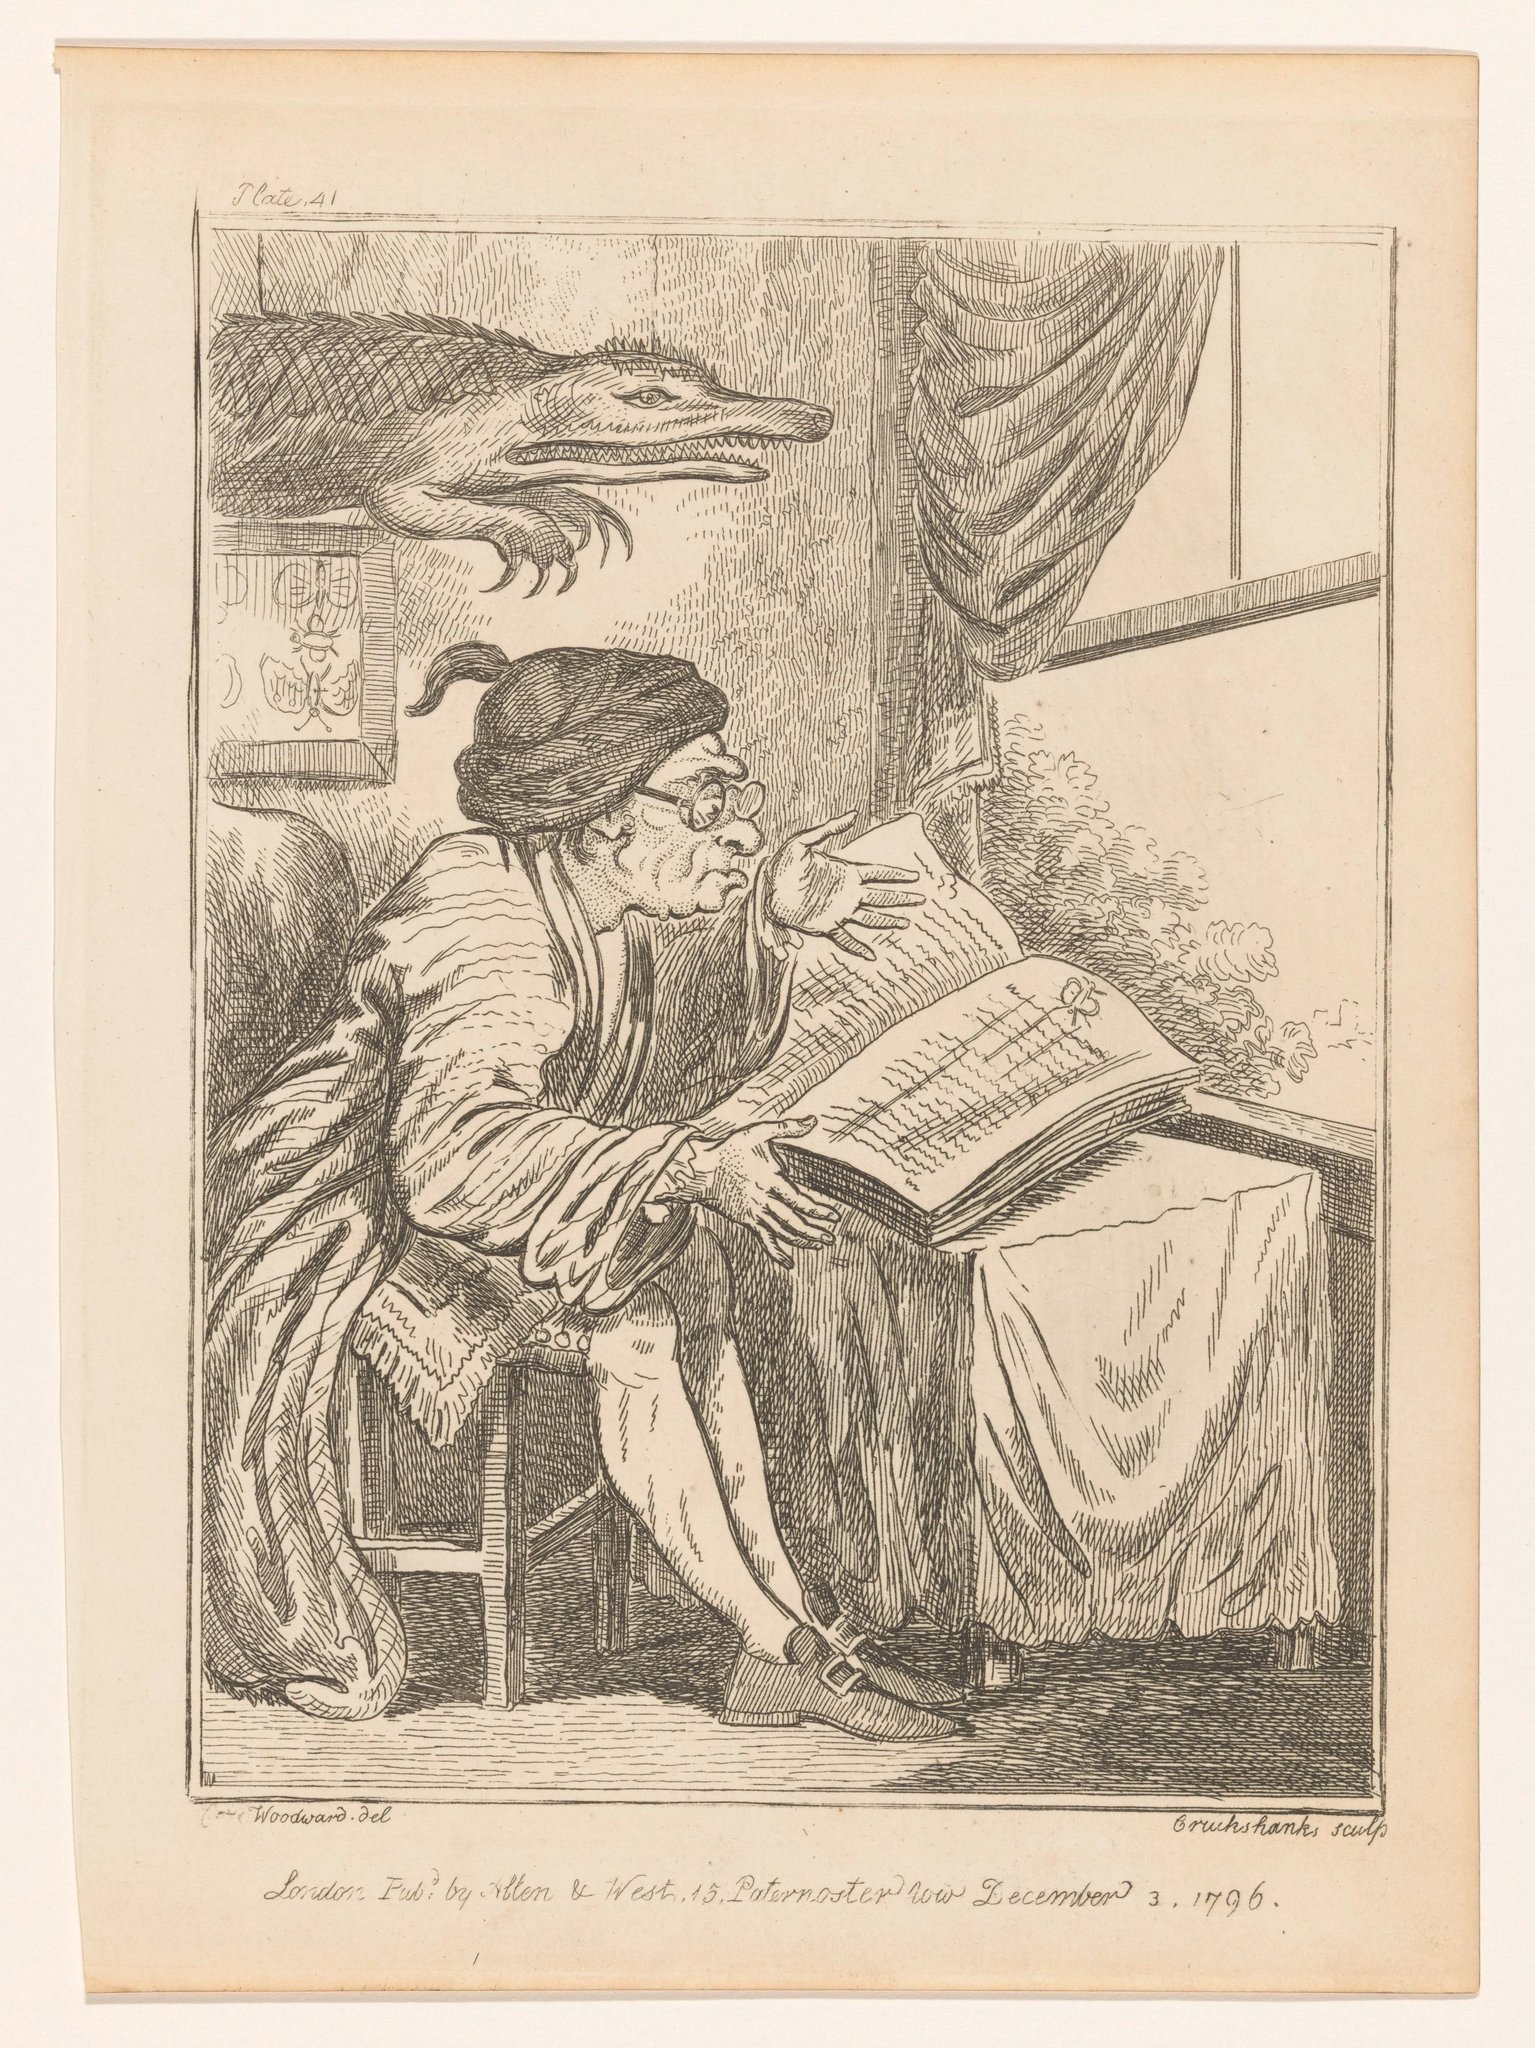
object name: print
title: Onderzoeker te Hertfordshire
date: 1712-1796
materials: paper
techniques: etching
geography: london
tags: reading, crocodiles: crocodile, book, political caricatures and satires, insects: fly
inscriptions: collector's mark: Lugt 2228, collector's mark: Lugt 4779, collector's mark: Lugt 4780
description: Een man leest een boek voor een open raam, met zijn handen jaagt hij een vlieg weg die op de pagina is gaan zitten. Aan het plafond hangt een opgezette krokodil en aan de muur hangen opgezette insecten in een lijst. Linksboven genummerd: Plate 41.